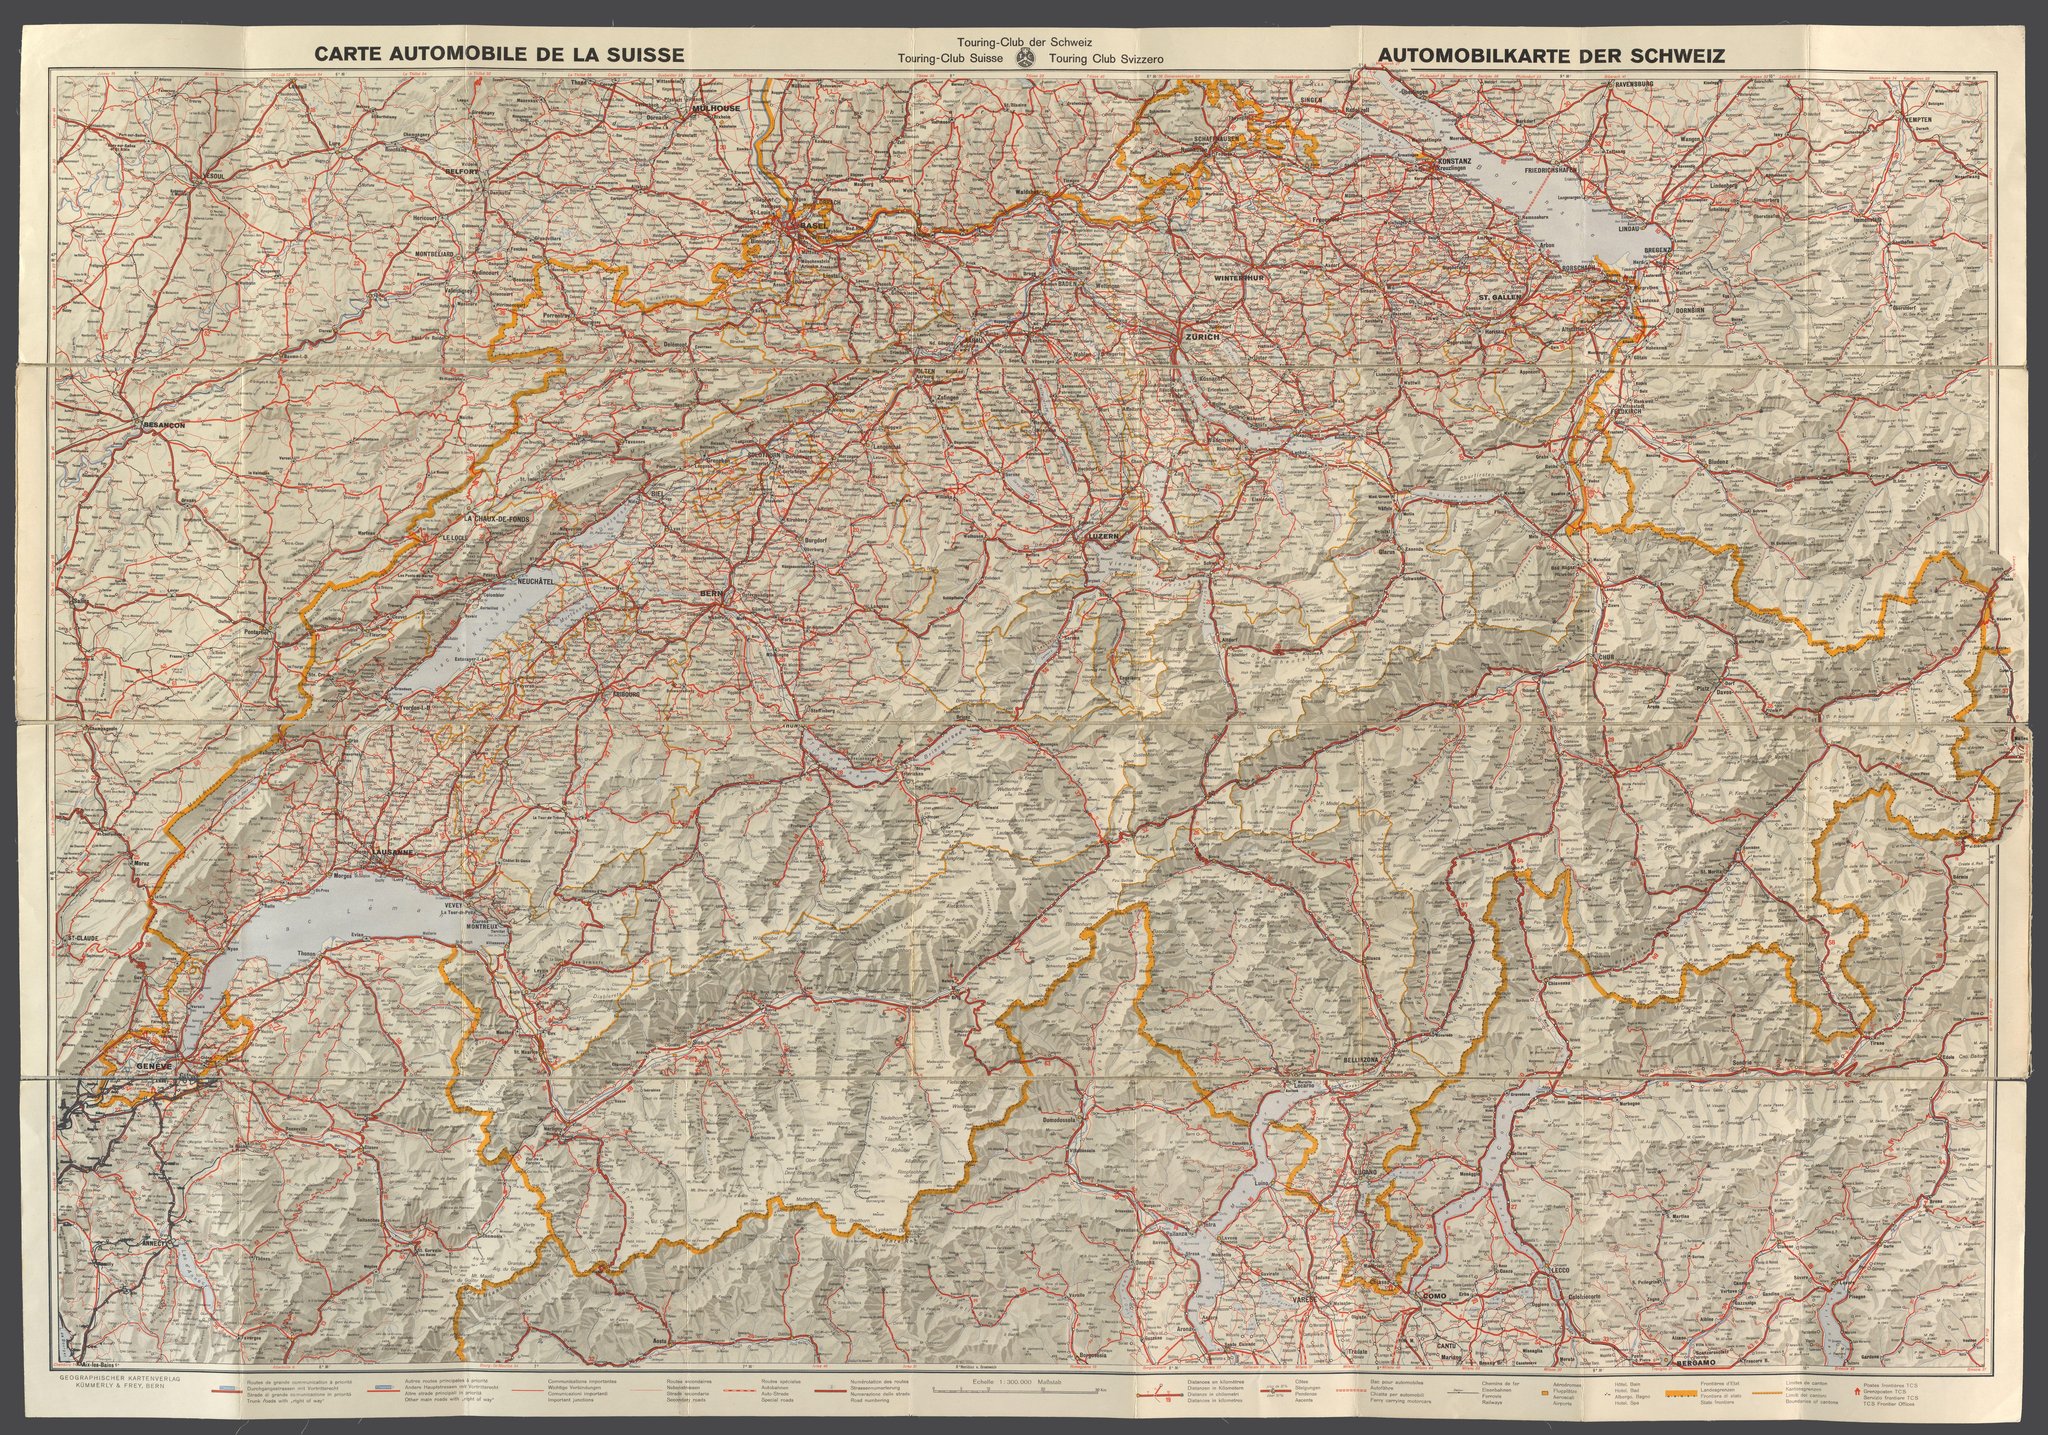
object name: print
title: Kaart van Zwitserland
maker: Anonymous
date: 1900-1999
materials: cotton, paper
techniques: lithograph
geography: bern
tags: maps of cities, switzerland